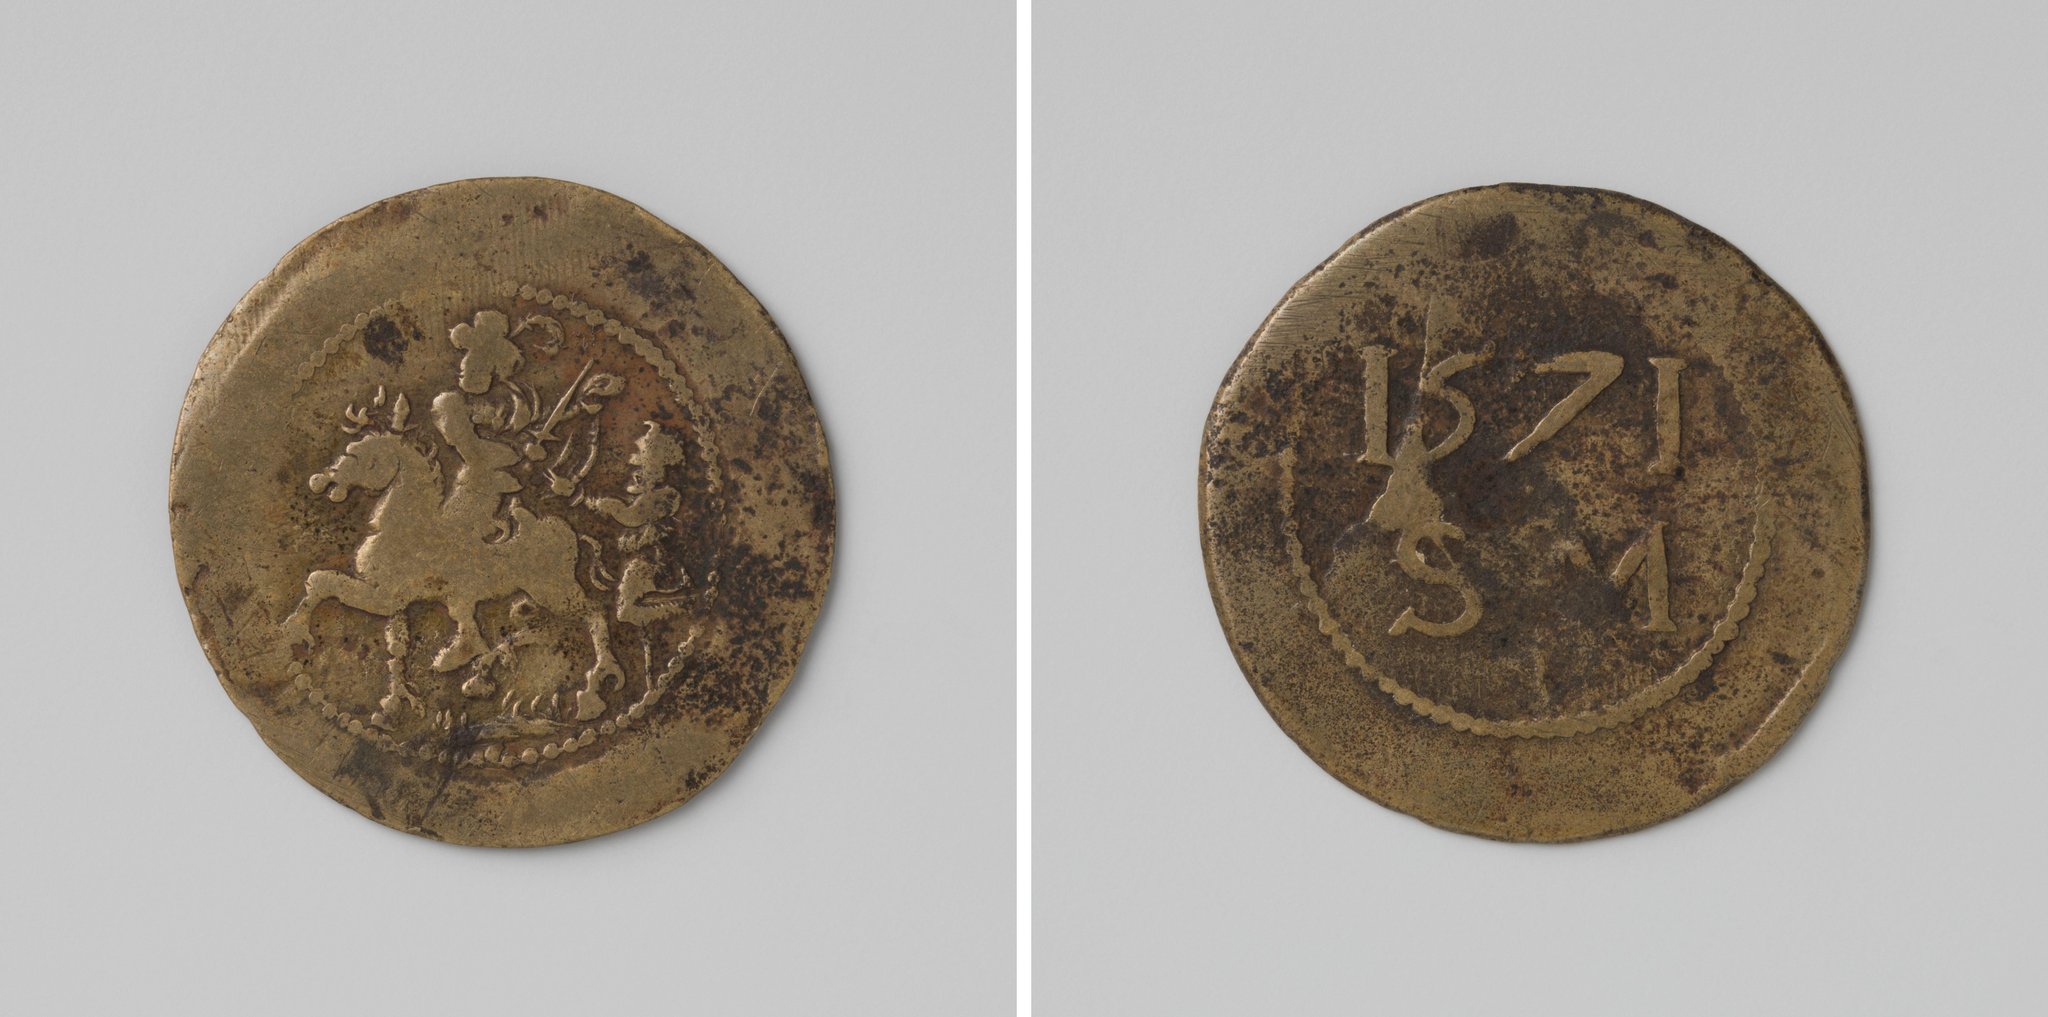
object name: devotional medal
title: Sint Maarten, penning met no. 5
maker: Anonymous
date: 1571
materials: brass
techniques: striking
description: Messing penning. Voorzijde: naar links gewende Sint Maarten met gepluimde hoed te paard snijdt met zwaard mantel door om gedeelte te geven aan naast hem staande man met stok binnen parelrand; ingeslagen, op lichaam van paard: cijfer 5. Keerzijde: letters S en M onder jaartal binnen parelrand